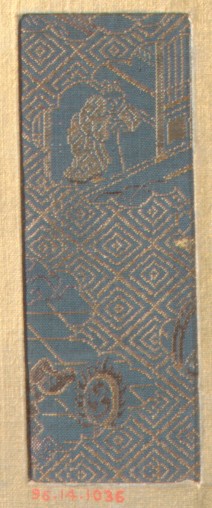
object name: piece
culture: japanese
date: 1701-1900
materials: silk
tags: human figures